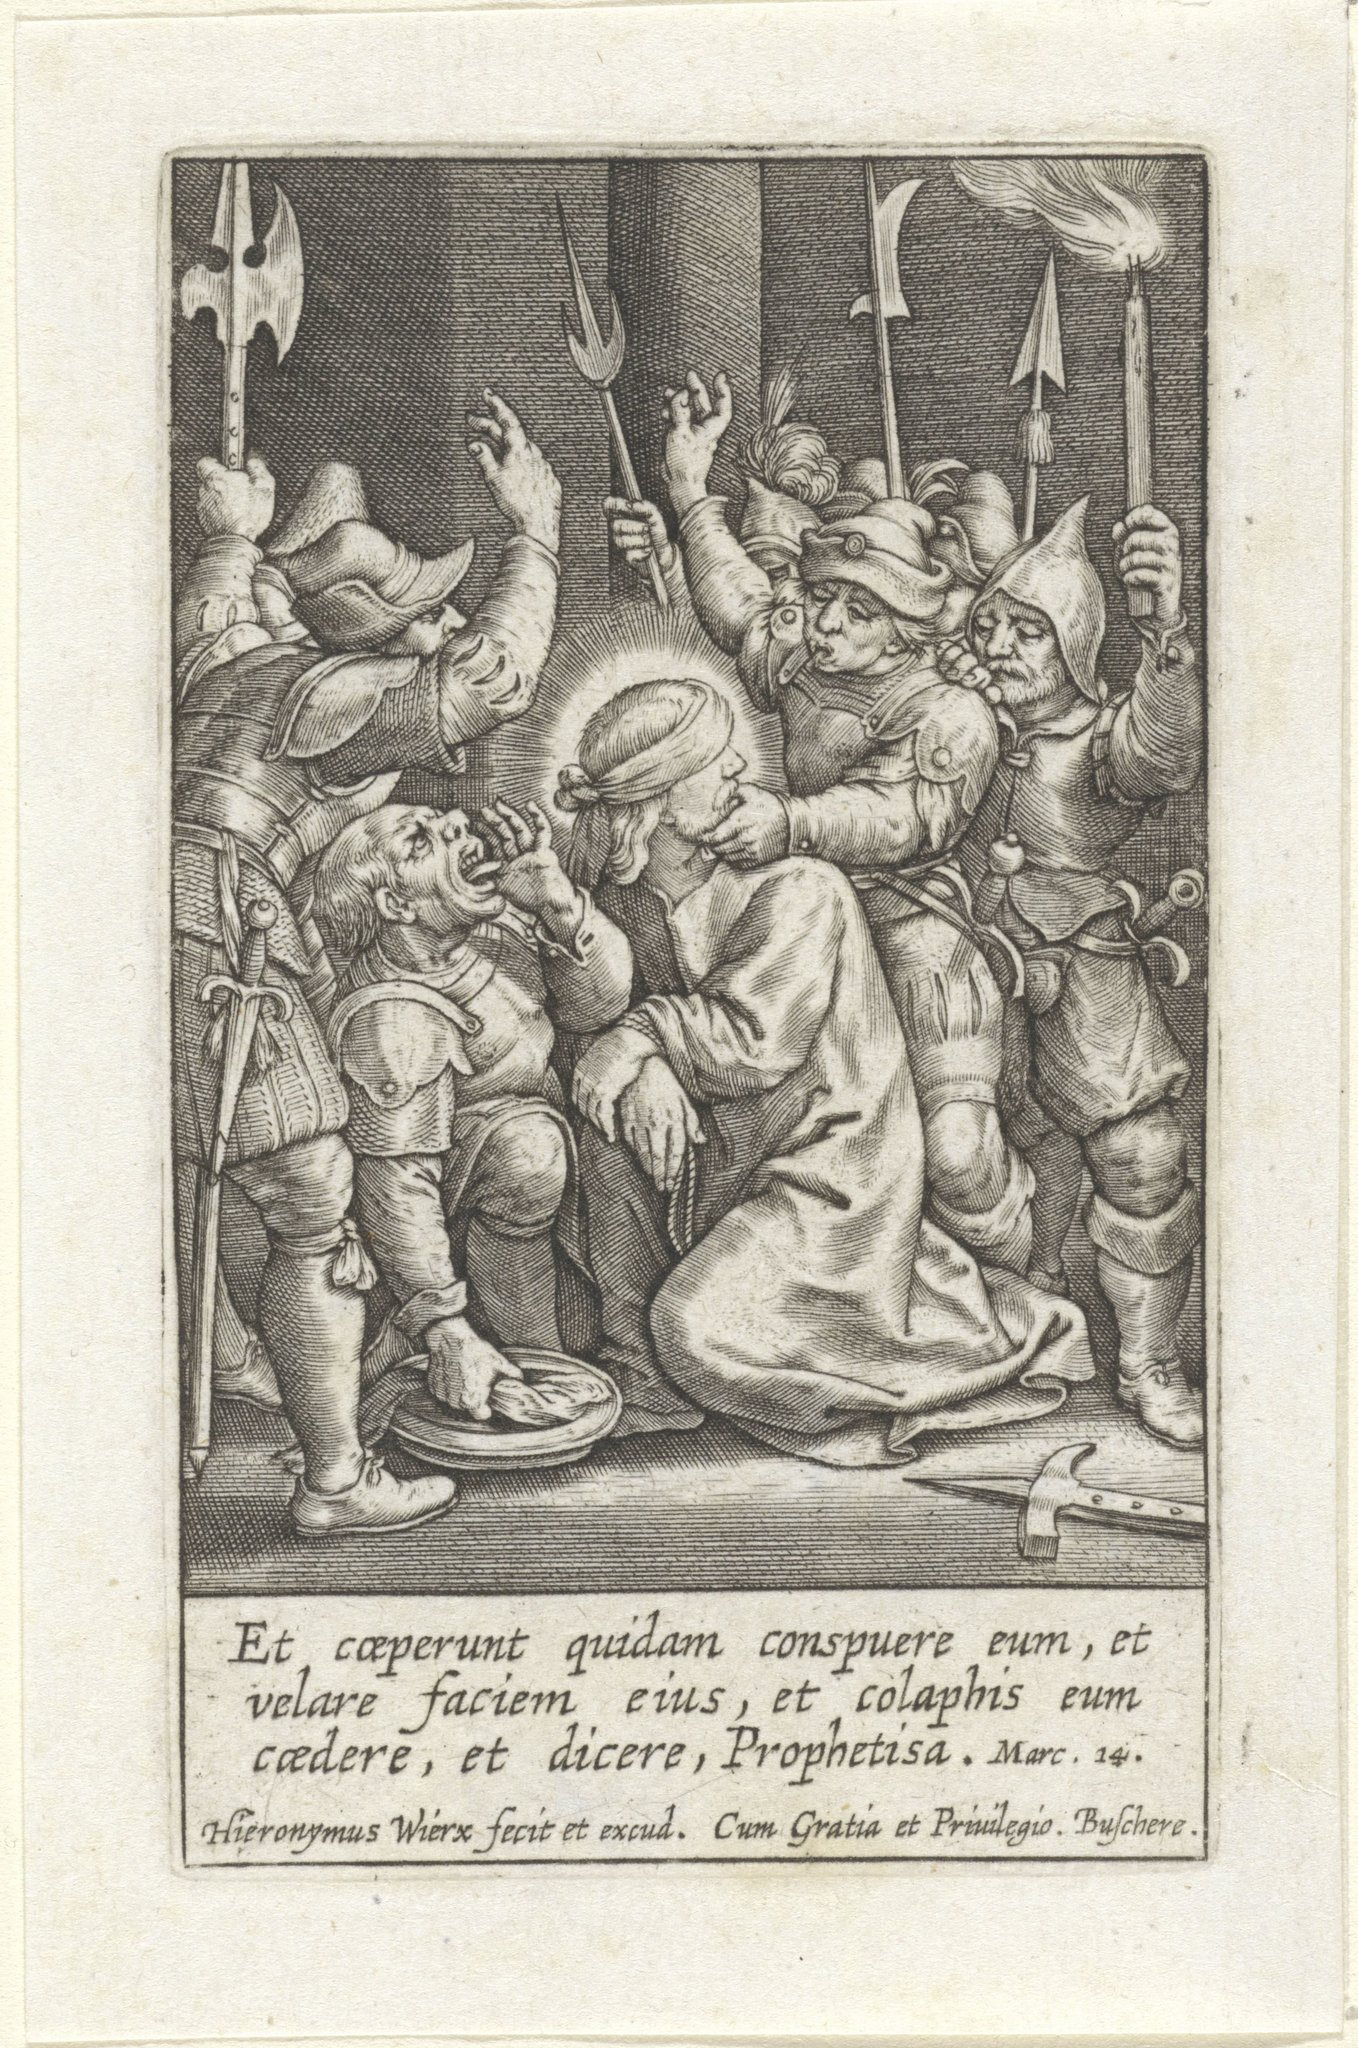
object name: print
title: Passie van Christus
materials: paper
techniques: engraving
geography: antwerp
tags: in pilate's palace christ is mocked by soldiers (luke 22:63-65)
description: De geblinddoekte Christus wordt bespot door de soldaten. Ze bespugen hem en slaan hem in het gezicht. In de marge een drieregelig Bijbelcitaat uit Mar. 14 in het Latijn.